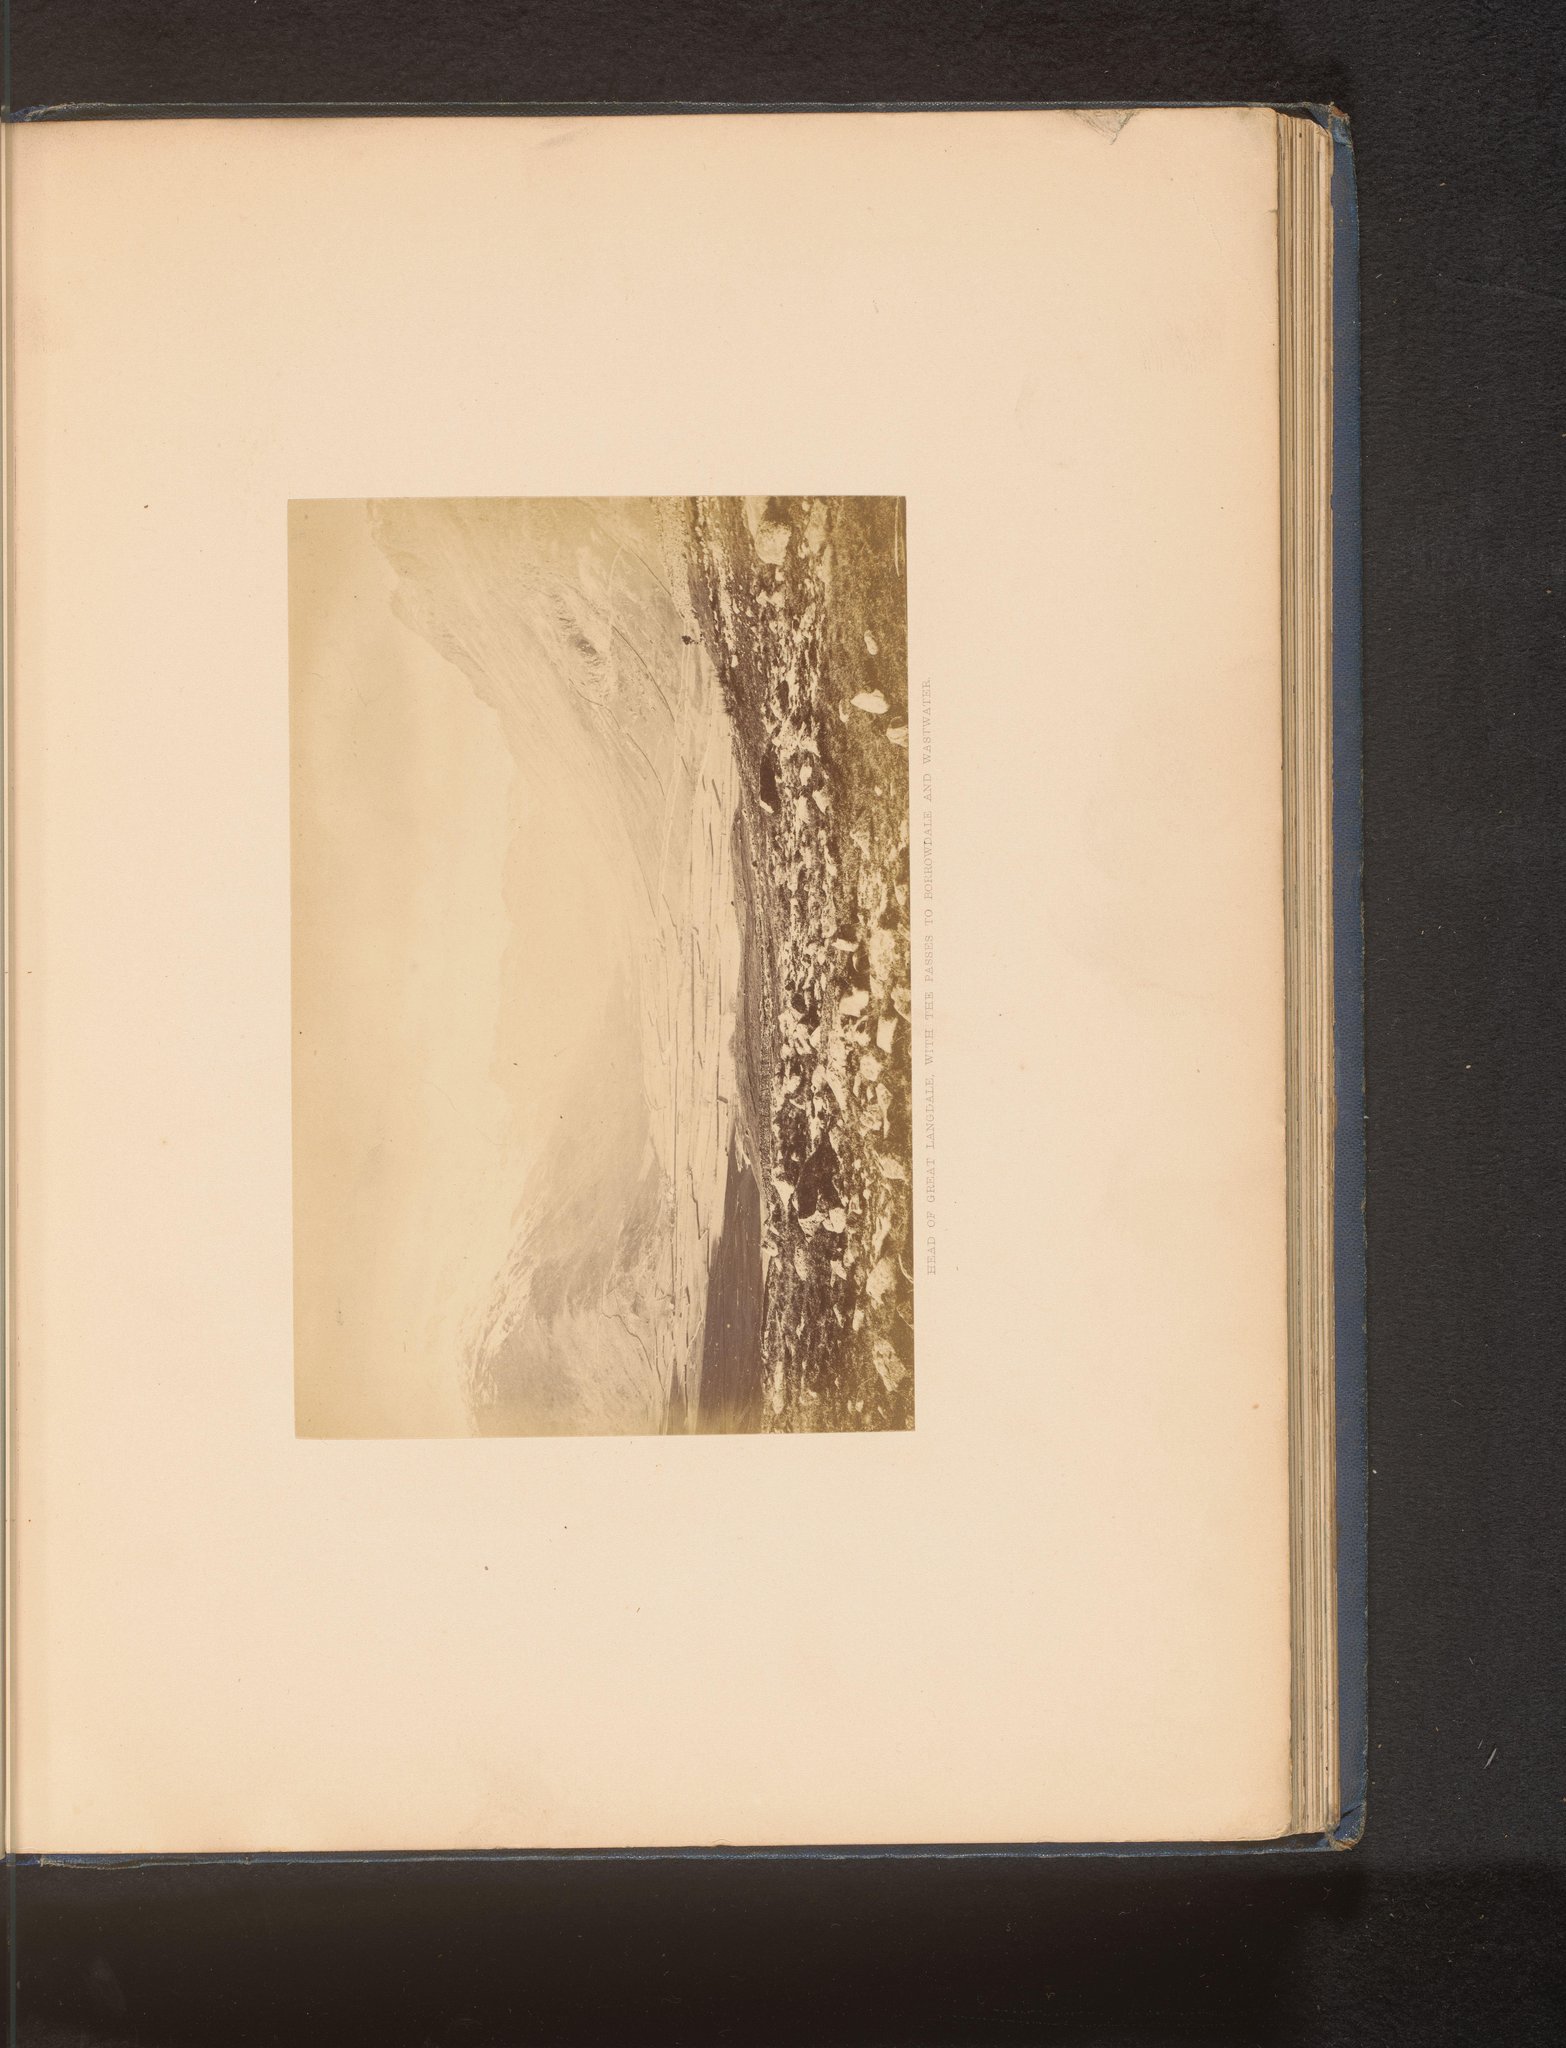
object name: photograph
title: Head of Great Langdale, with the passes to Borrowdale and Wastwater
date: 1857-1867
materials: photographic support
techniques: albumen print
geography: lake district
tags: dale, valley